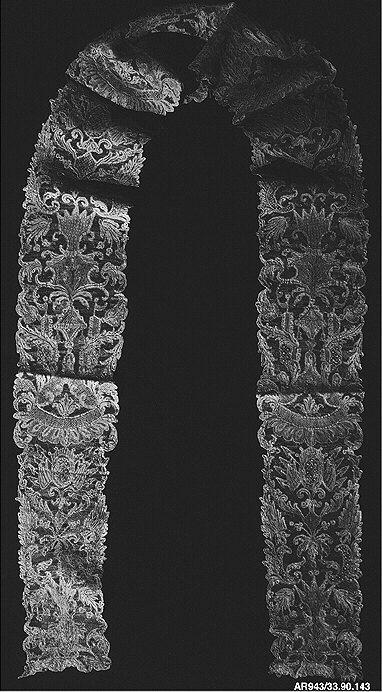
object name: lappet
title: Pair of lappets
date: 1701-1733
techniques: lace